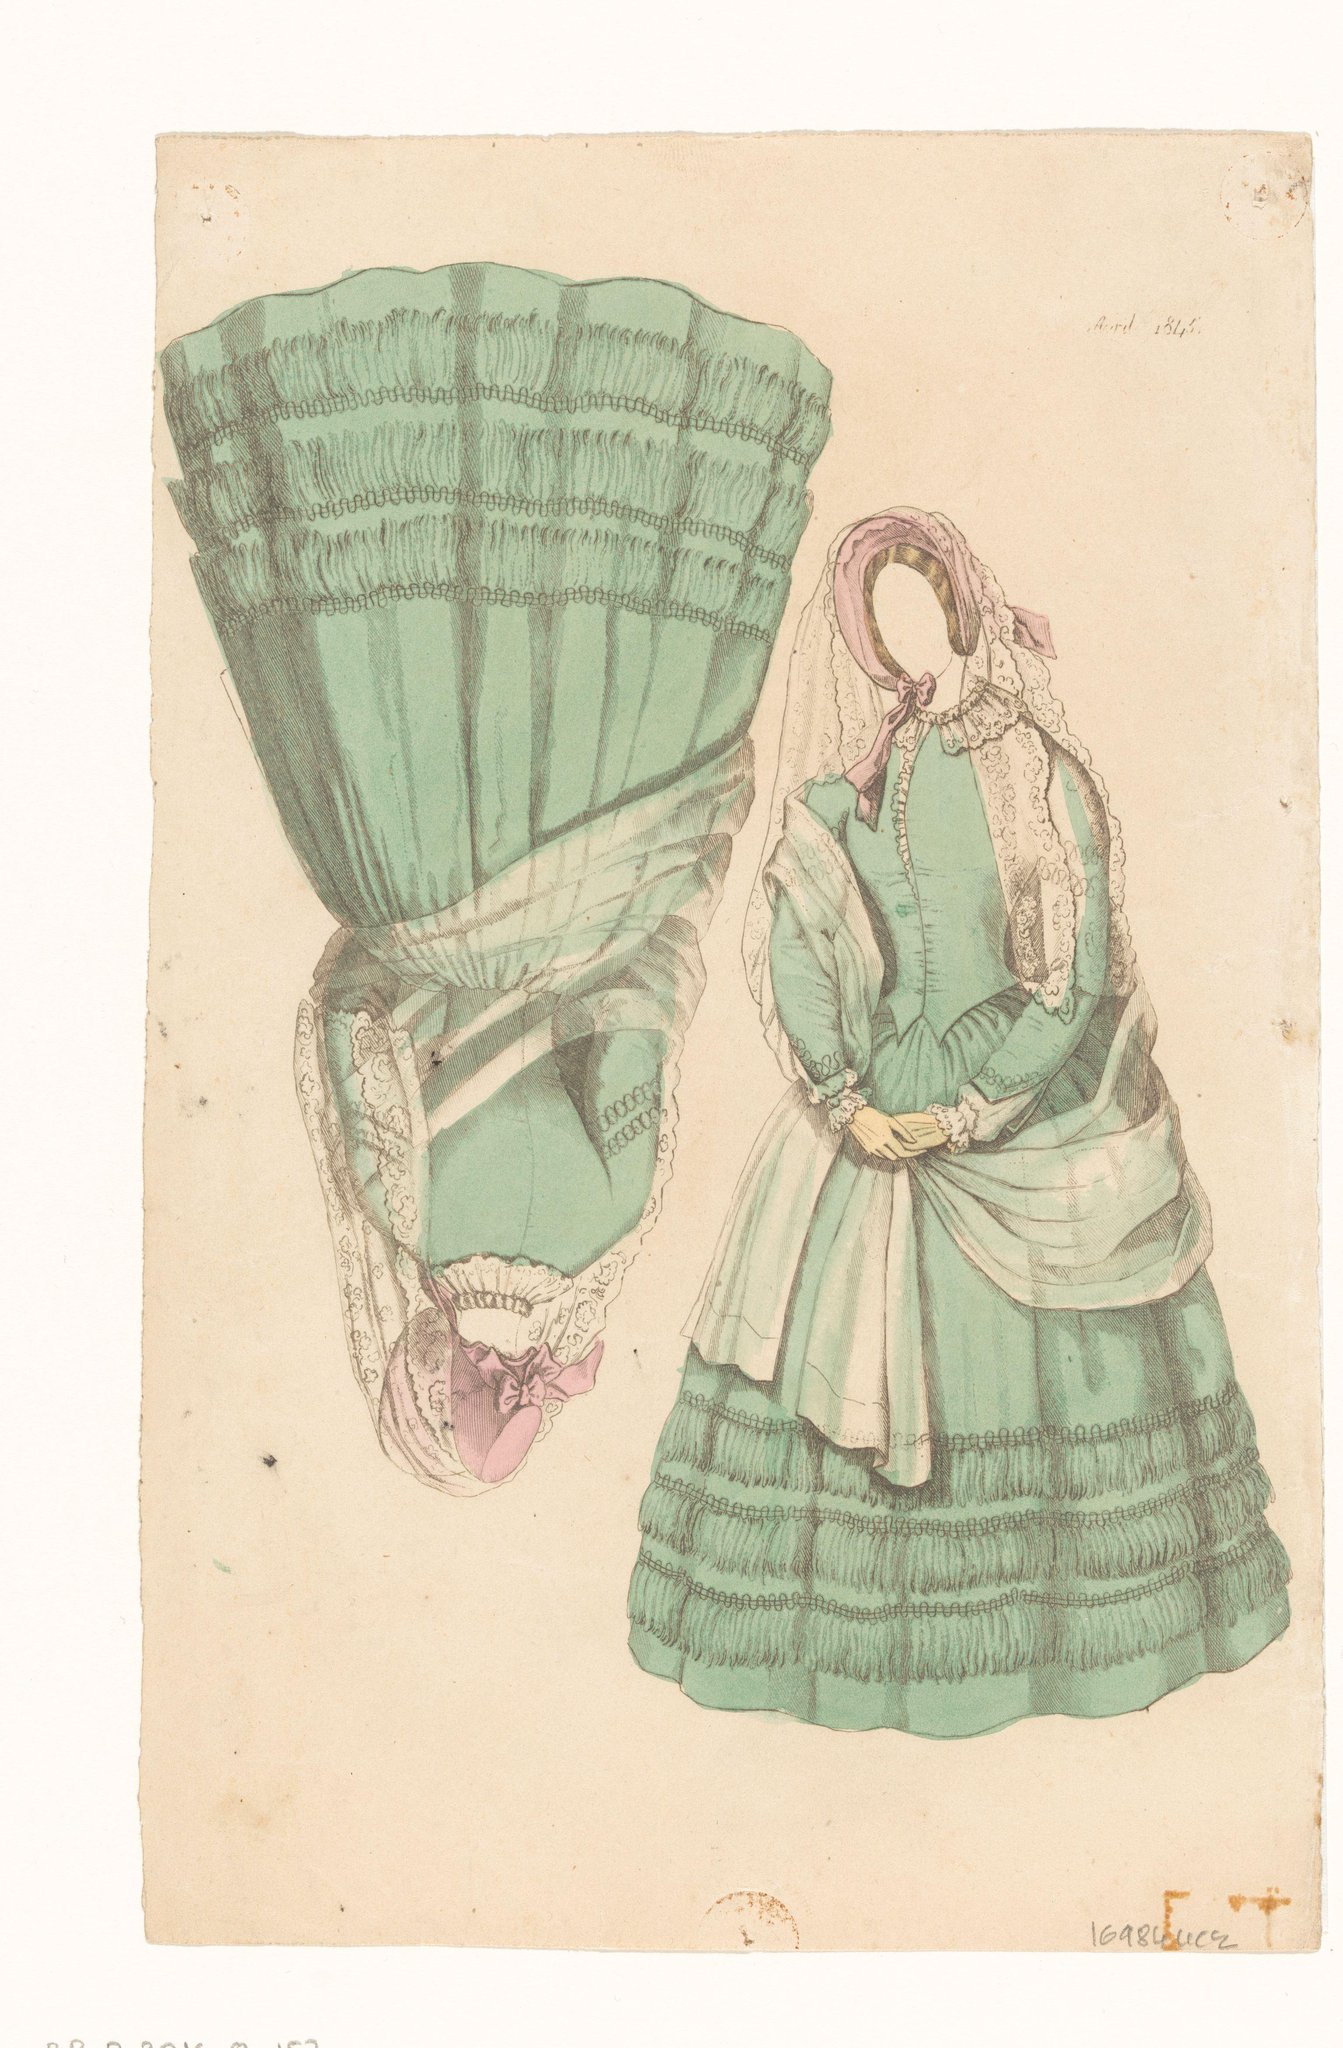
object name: fashion print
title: Uitknippop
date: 1804-1845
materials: paper, ink, watercolor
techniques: etching, hand coloring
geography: europe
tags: fashion plates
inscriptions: collector's mark: Lugt 2228